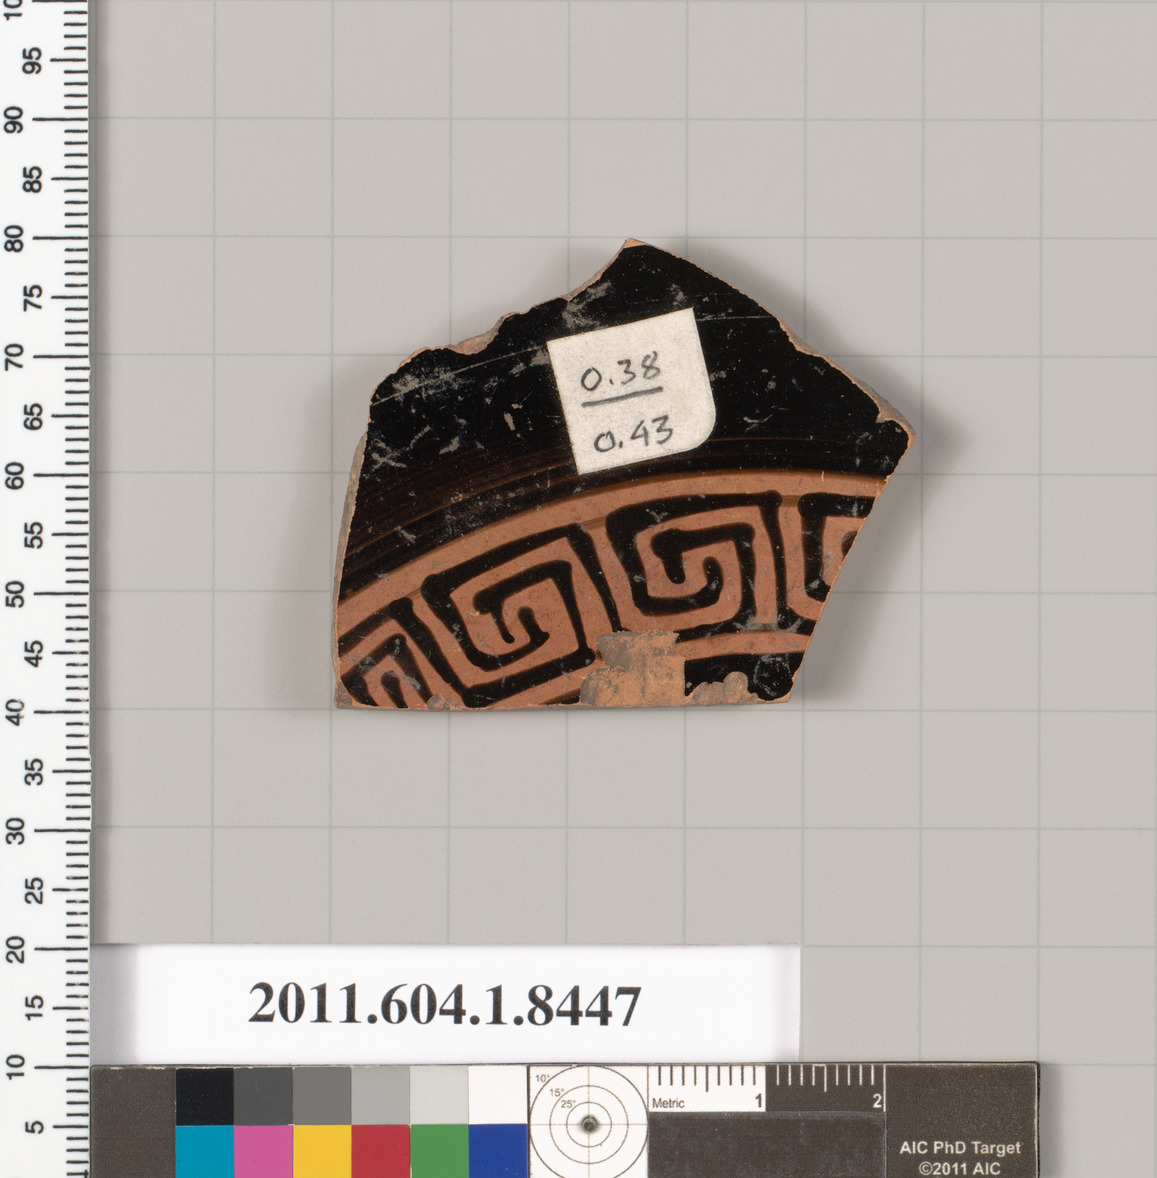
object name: kylix fragment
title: Terracotta fragment of a kylix (drinking cup)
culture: greek, attic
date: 375-351 BCE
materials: terracotta